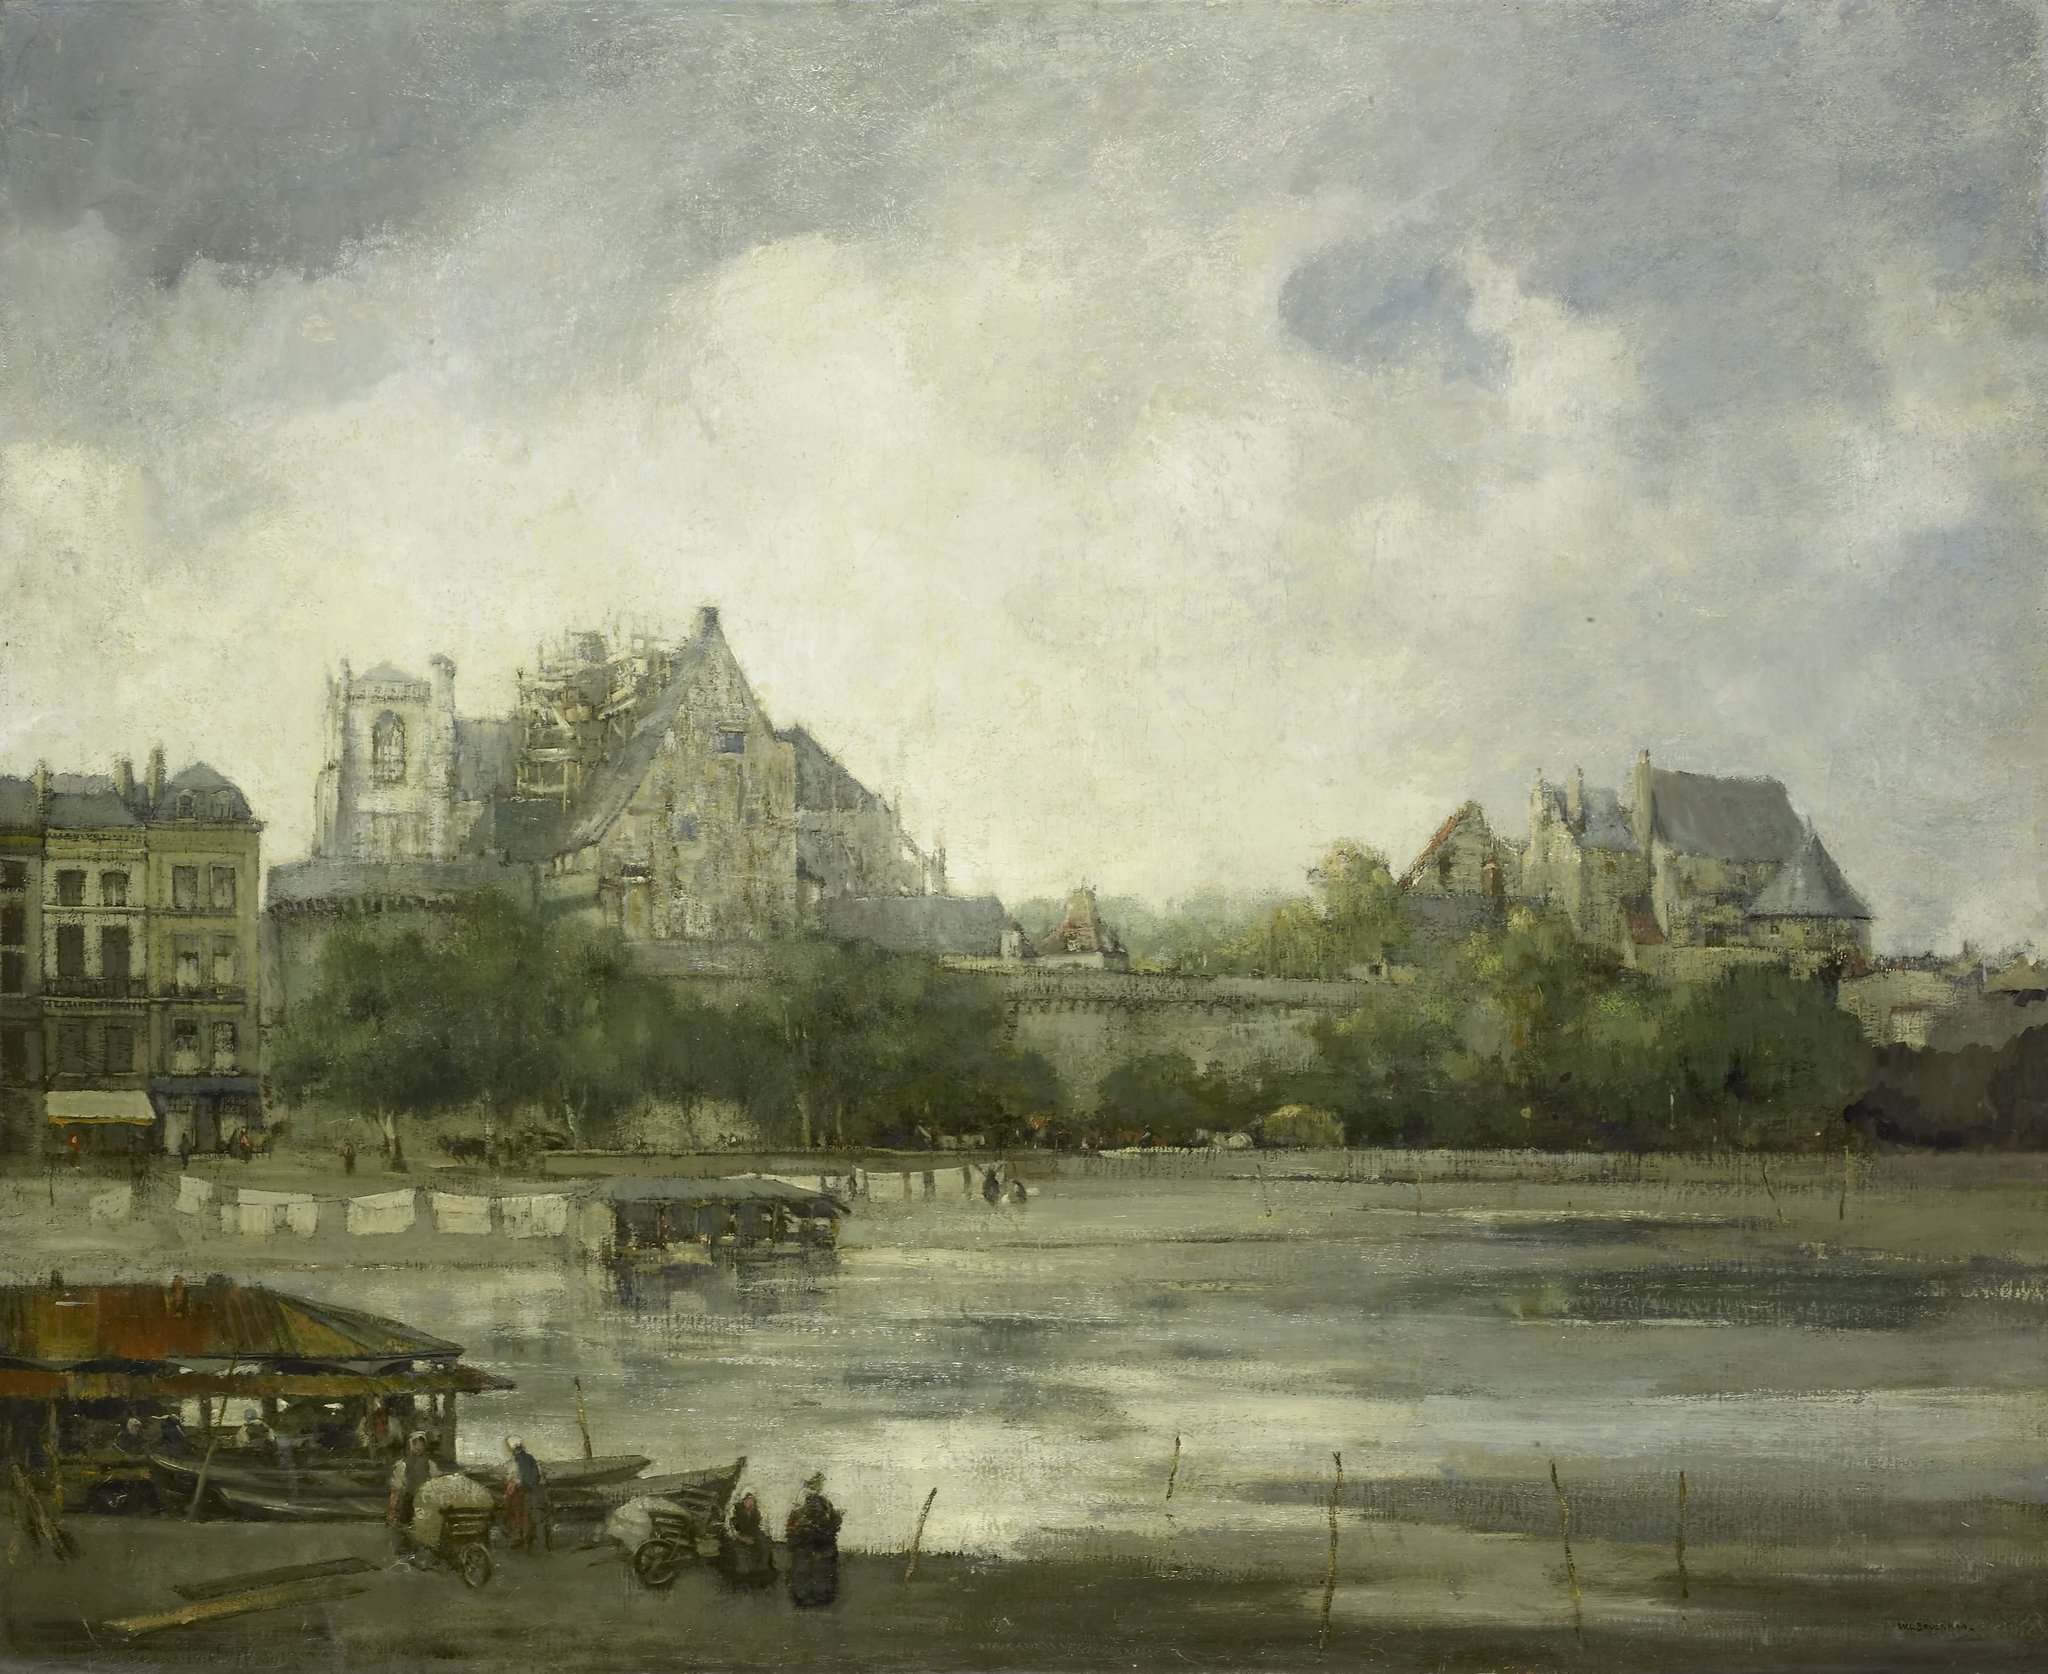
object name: painting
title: View of Nantes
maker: willem leendert bruckman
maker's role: painter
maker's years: 1866-1928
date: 1890-1928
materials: canvas, oil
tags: prospect of city, town panorama, silhouette of city (+ city(-scape) with figures, staffage)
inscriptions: signature: ‘W.L. Bruckman’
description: Gezicht op Nantes. Gezicht over de Loire op de stadsmuren, de kathedraal van St.-Pierre en het kasteel. Op de voorgrond worden boten uitgeladen, links hangen lakens bij een wasserij te drogen.